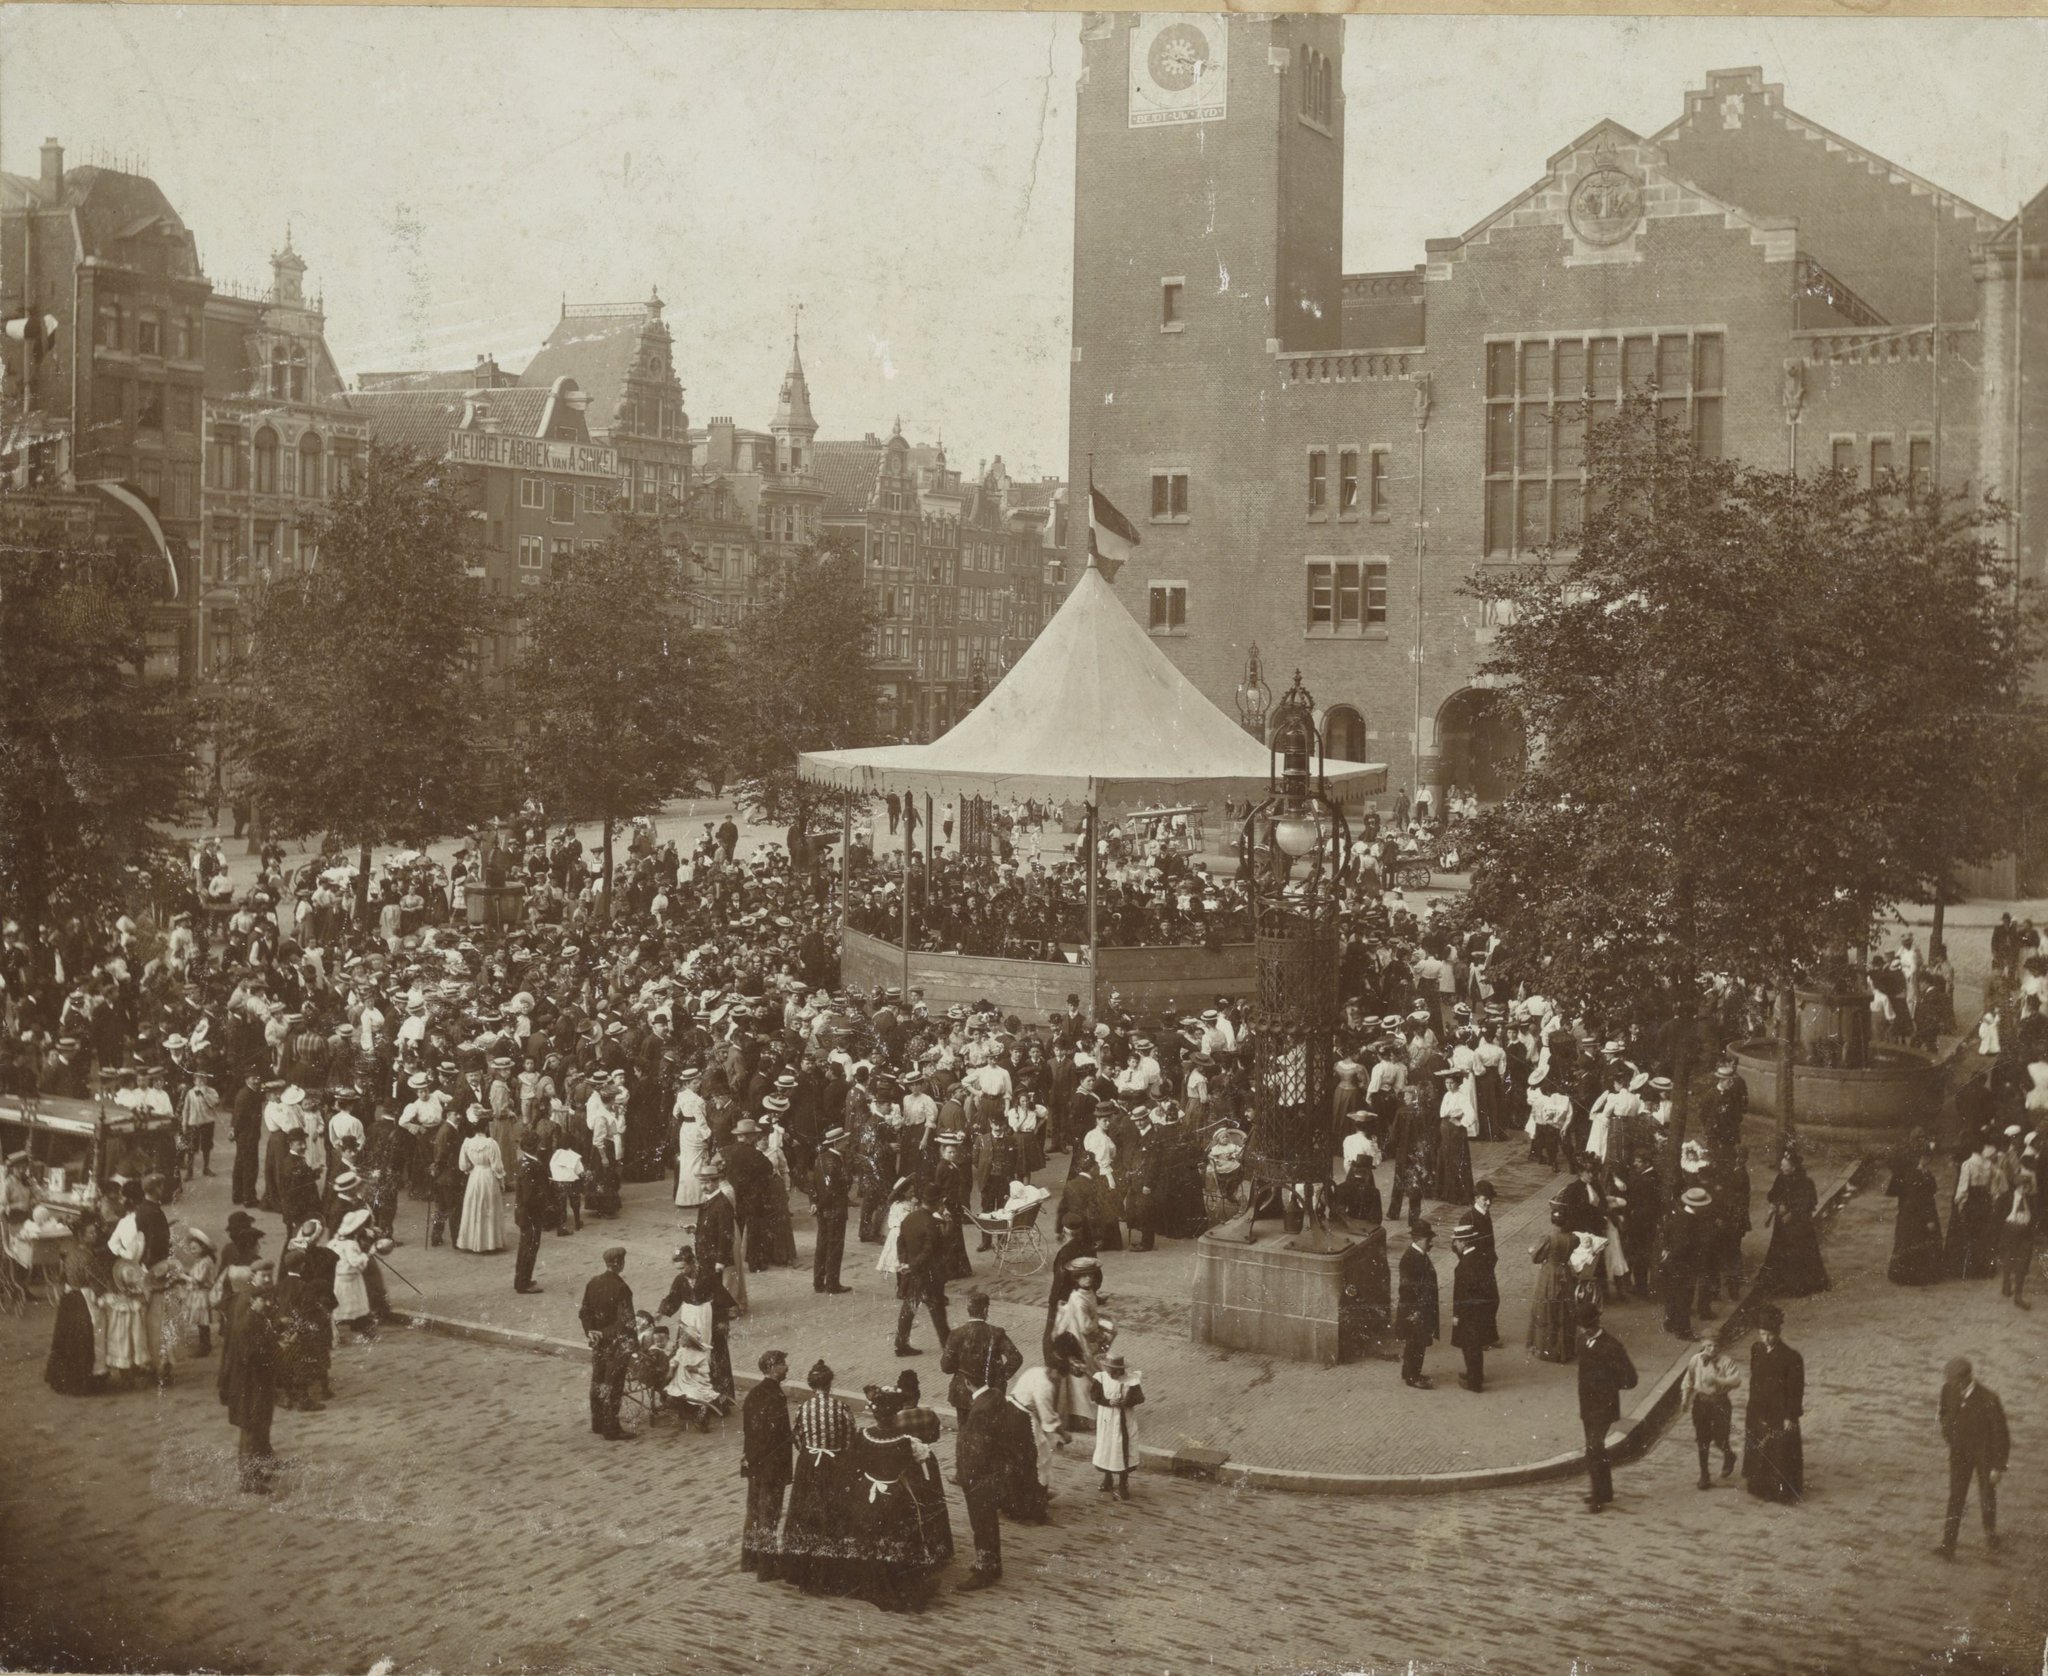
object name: photograph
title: Amsterdamsche Postharmonie op het Beursplein te Amsterdam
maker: machiel hendricus laddé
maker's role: fotograaf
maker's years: 1866-1932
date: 1907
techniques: albumen print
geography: amsterdam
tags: beursplein